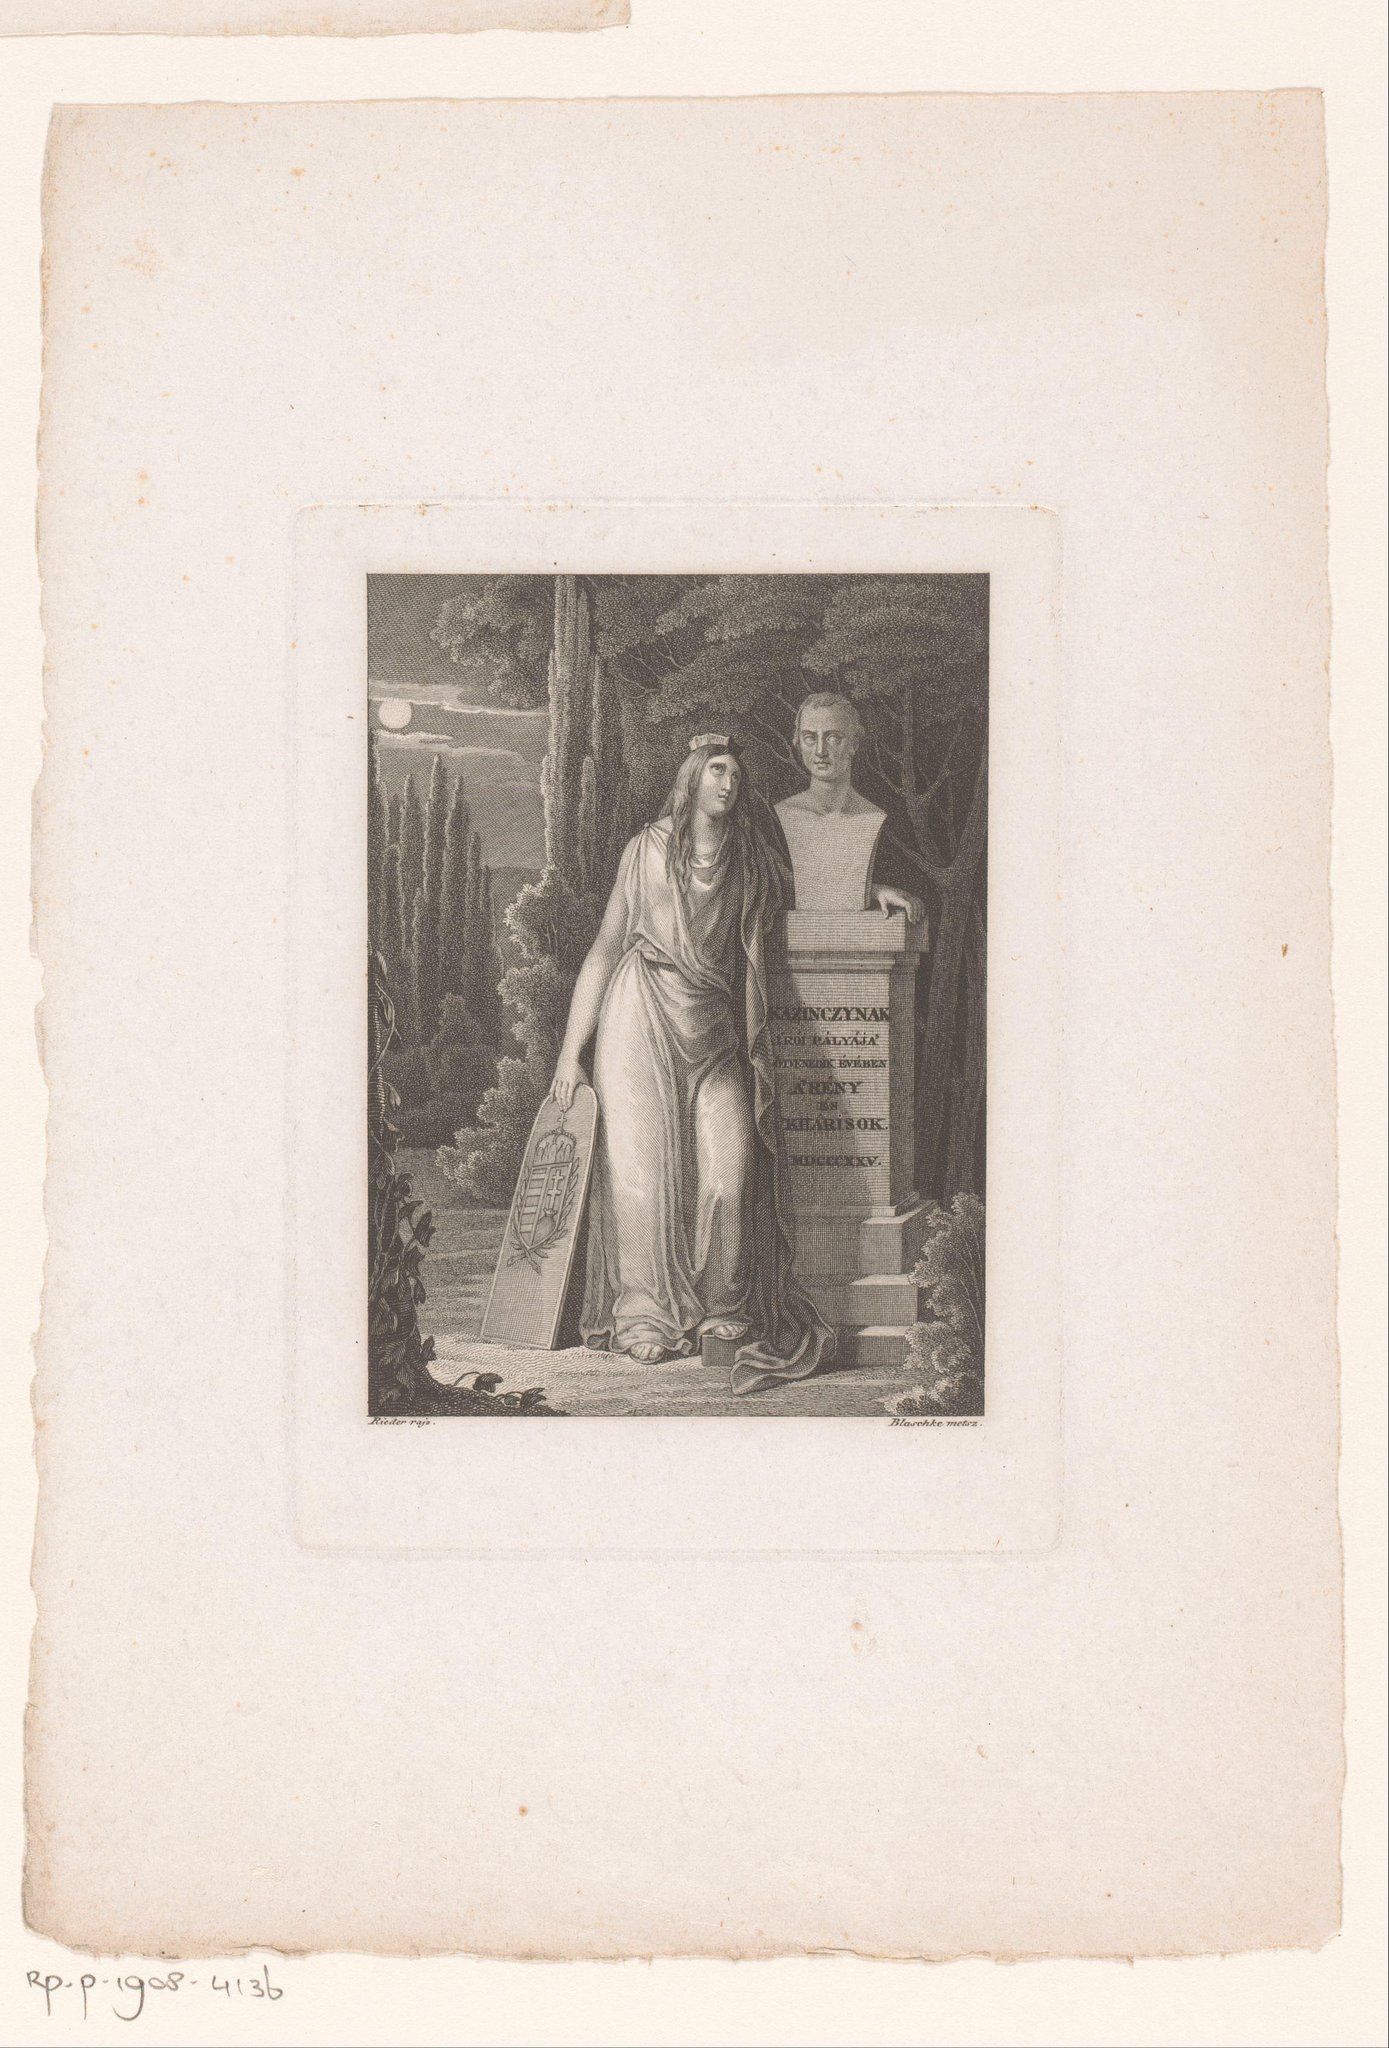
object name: print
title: Graftombe van Ferenc Kazinczy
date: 1780-1833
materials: paper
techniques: engraving, etching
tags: grave, tomb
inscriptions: collector's mark: Lugt 2228